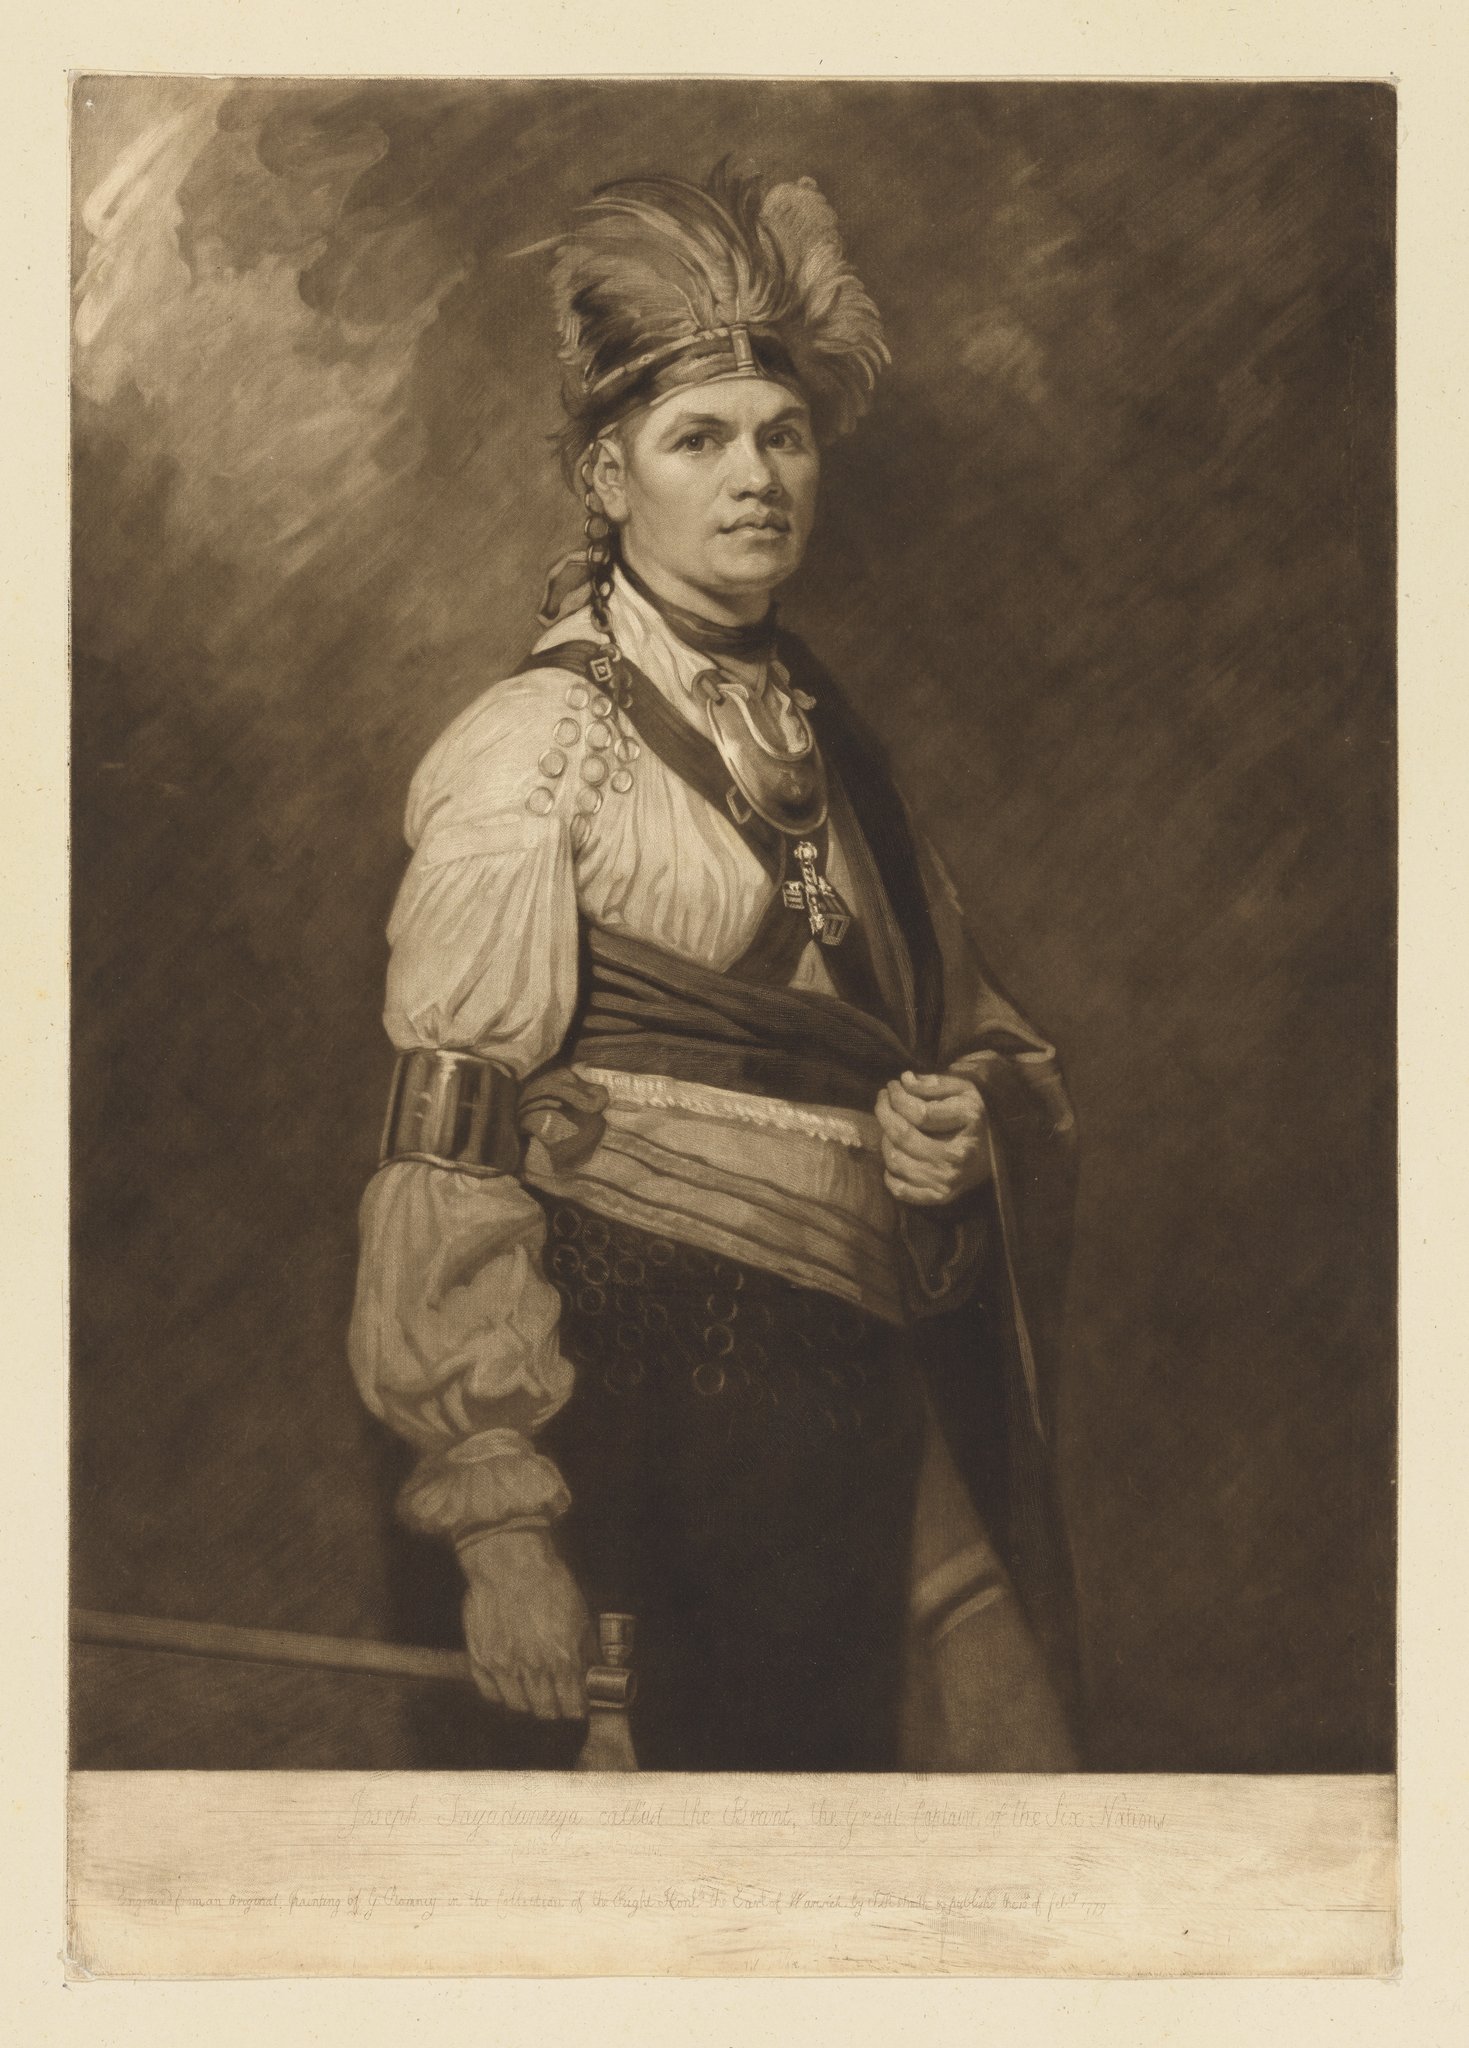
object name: print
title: Joseph Tayadaneega, called the Brant, the Great Captain of the Six Nations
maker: john raphael smith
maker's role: artist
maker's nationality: british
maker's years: 1751-1812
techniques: mezzotint